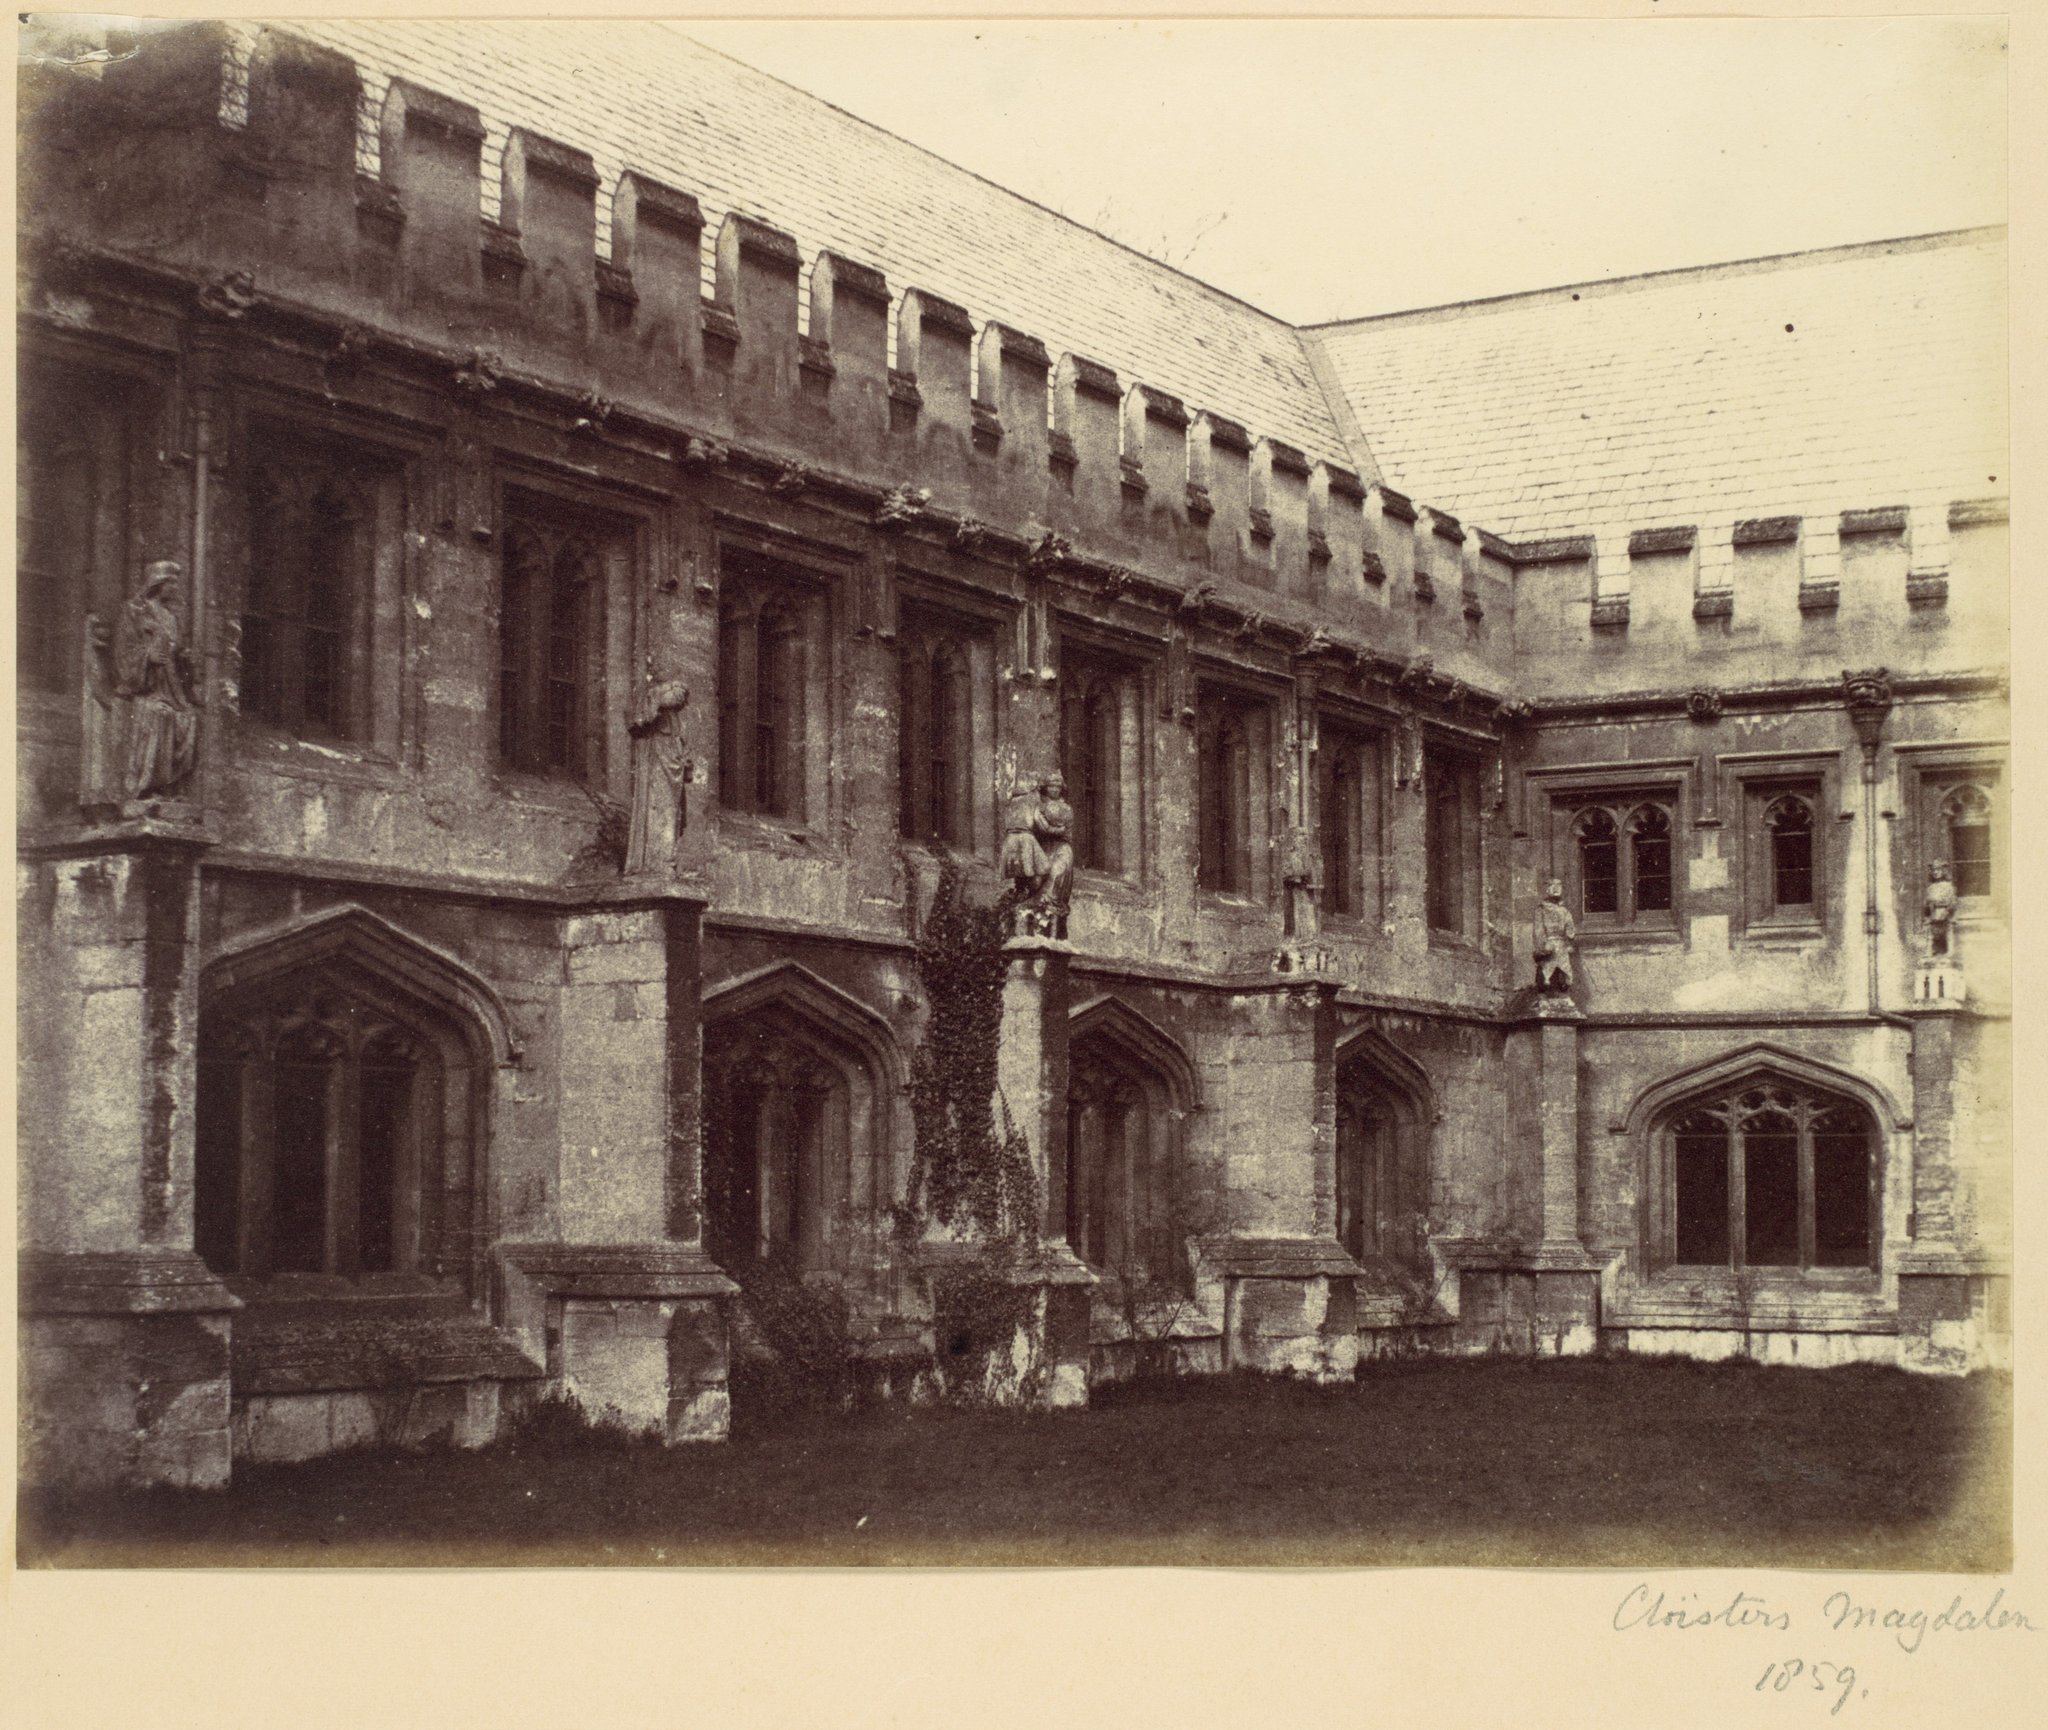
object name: photograph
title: Cloisters, Magdalen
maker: alfred capel cure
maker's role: artist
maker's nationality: british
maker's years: 1826-1896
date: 1859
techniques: albumen silver print, paper negative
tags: cloisters